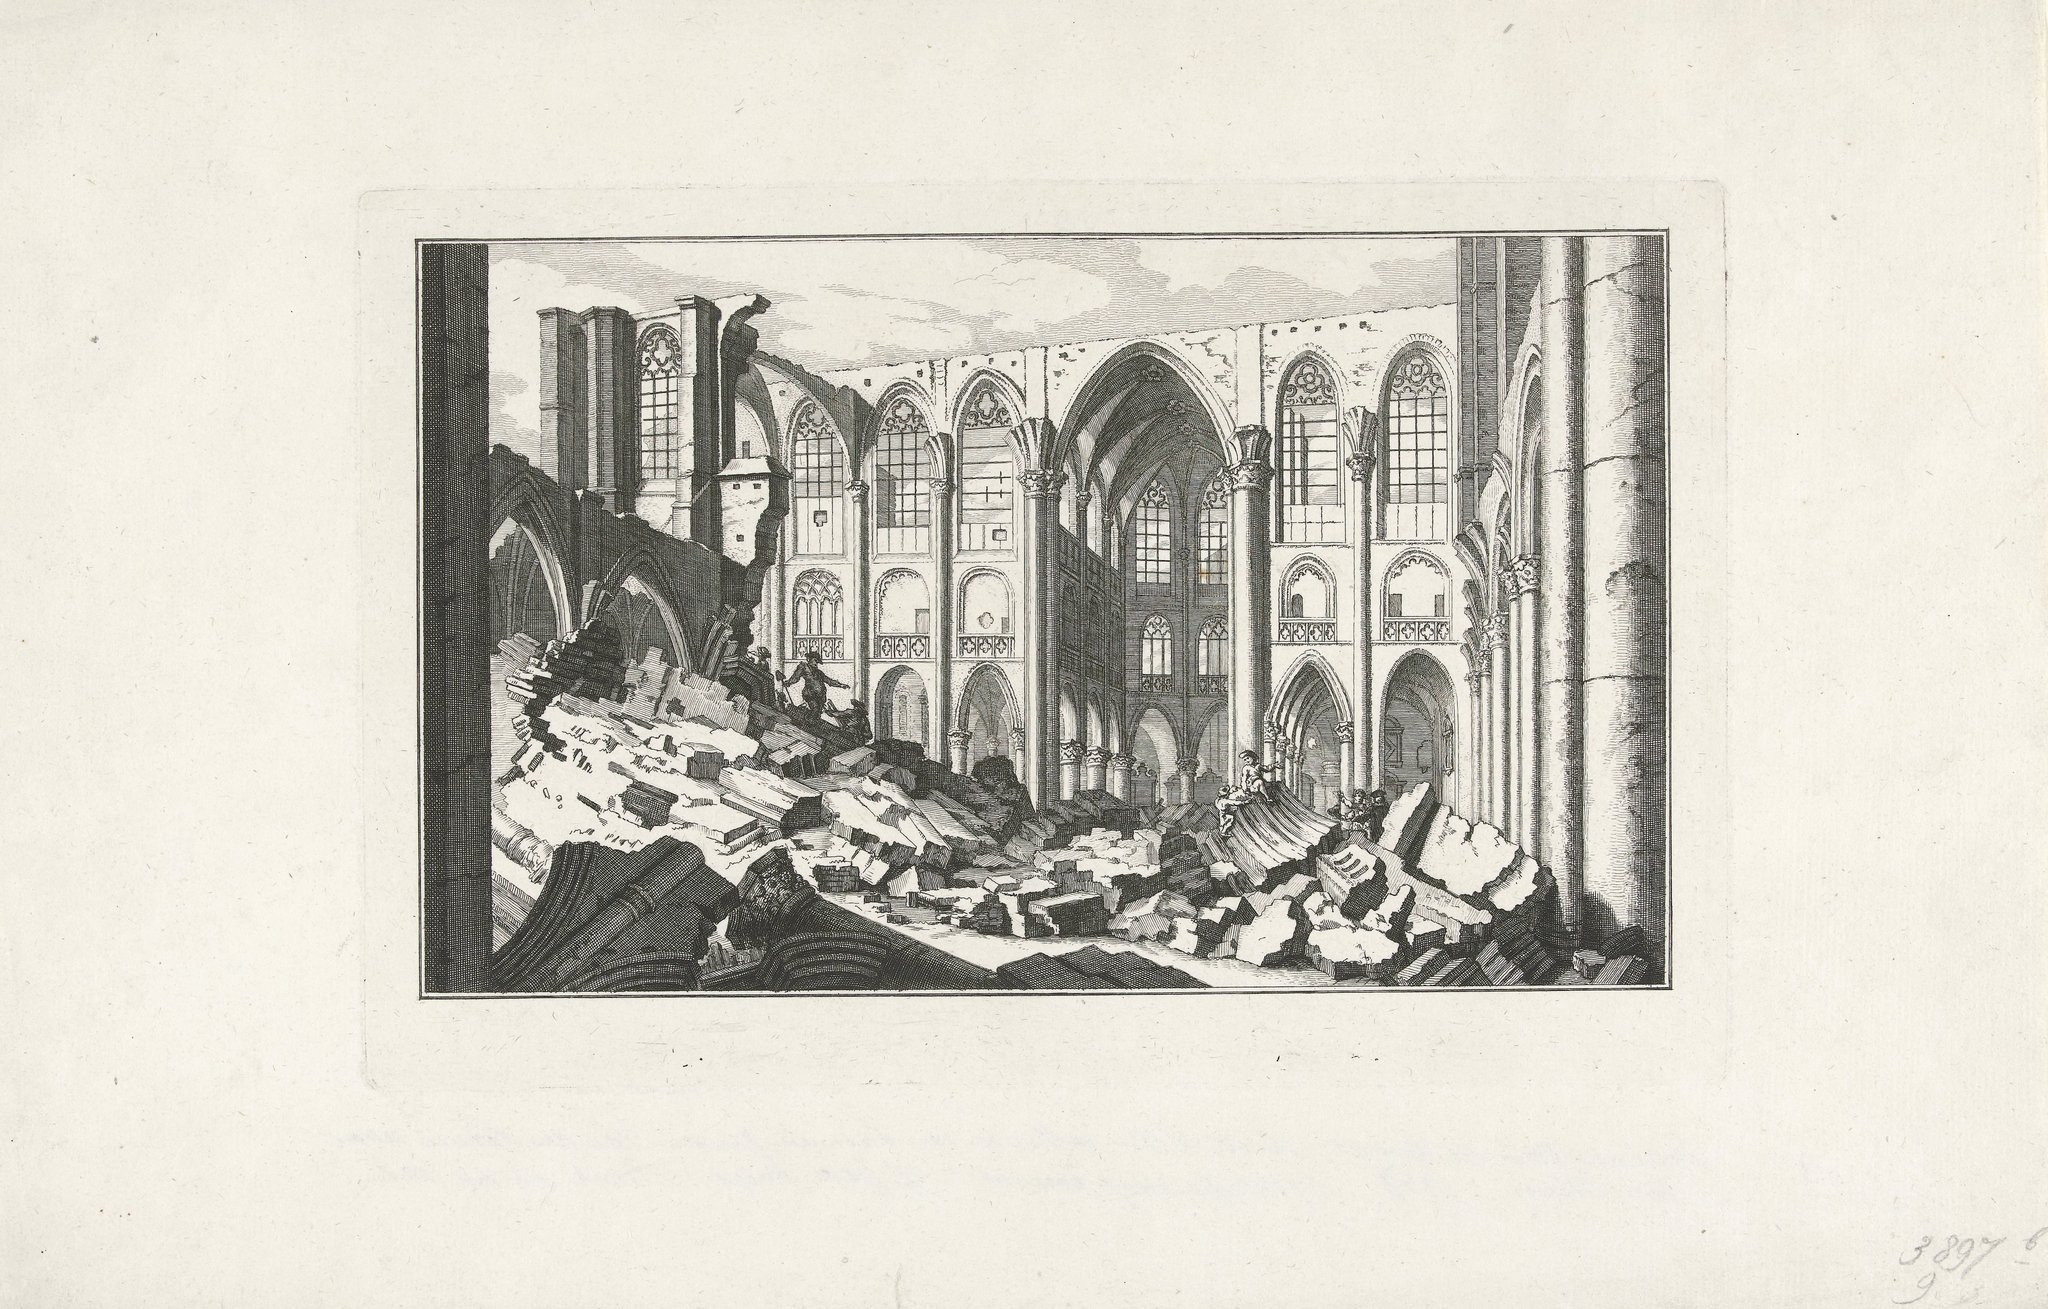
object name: print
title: Ruïne van de Grote Kerk van Bergen op Zoom, 1748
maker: simon fokke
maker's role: draughtsman, print maker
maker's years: 1712-1784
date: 1772-1780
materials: paper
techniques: etching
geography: northern netherlands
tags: ruin of church, monastery, etc., devastated, ruined place or city (~ warfare), bergen op zoom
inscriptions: collector's mark: Lugt 2228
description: Prent ook gebruikt in: Beschryving der stad Bergen op den Zoom (…). 1e druk. Amsterdam: Arend Fokke Simonsz., 1780. Muller geeft aan dat de prenten door Simon Fokke in 1772 naar de tekeningen van Pronk uit 1748 zijn vervaardigd. In de Collecties Thuis in Brabant (collecties in Brabantse musea en archieven) is een ontwerptekening (met inv.nr.: BC-Tha oai:tha.uvt.nl:709121) voor deze prent in de serie bewaard met de annotatie: Hoogstraat. na t Leven geschest (sic) door C.Pronk 1748. opgetekent door S. Fokke 1772.